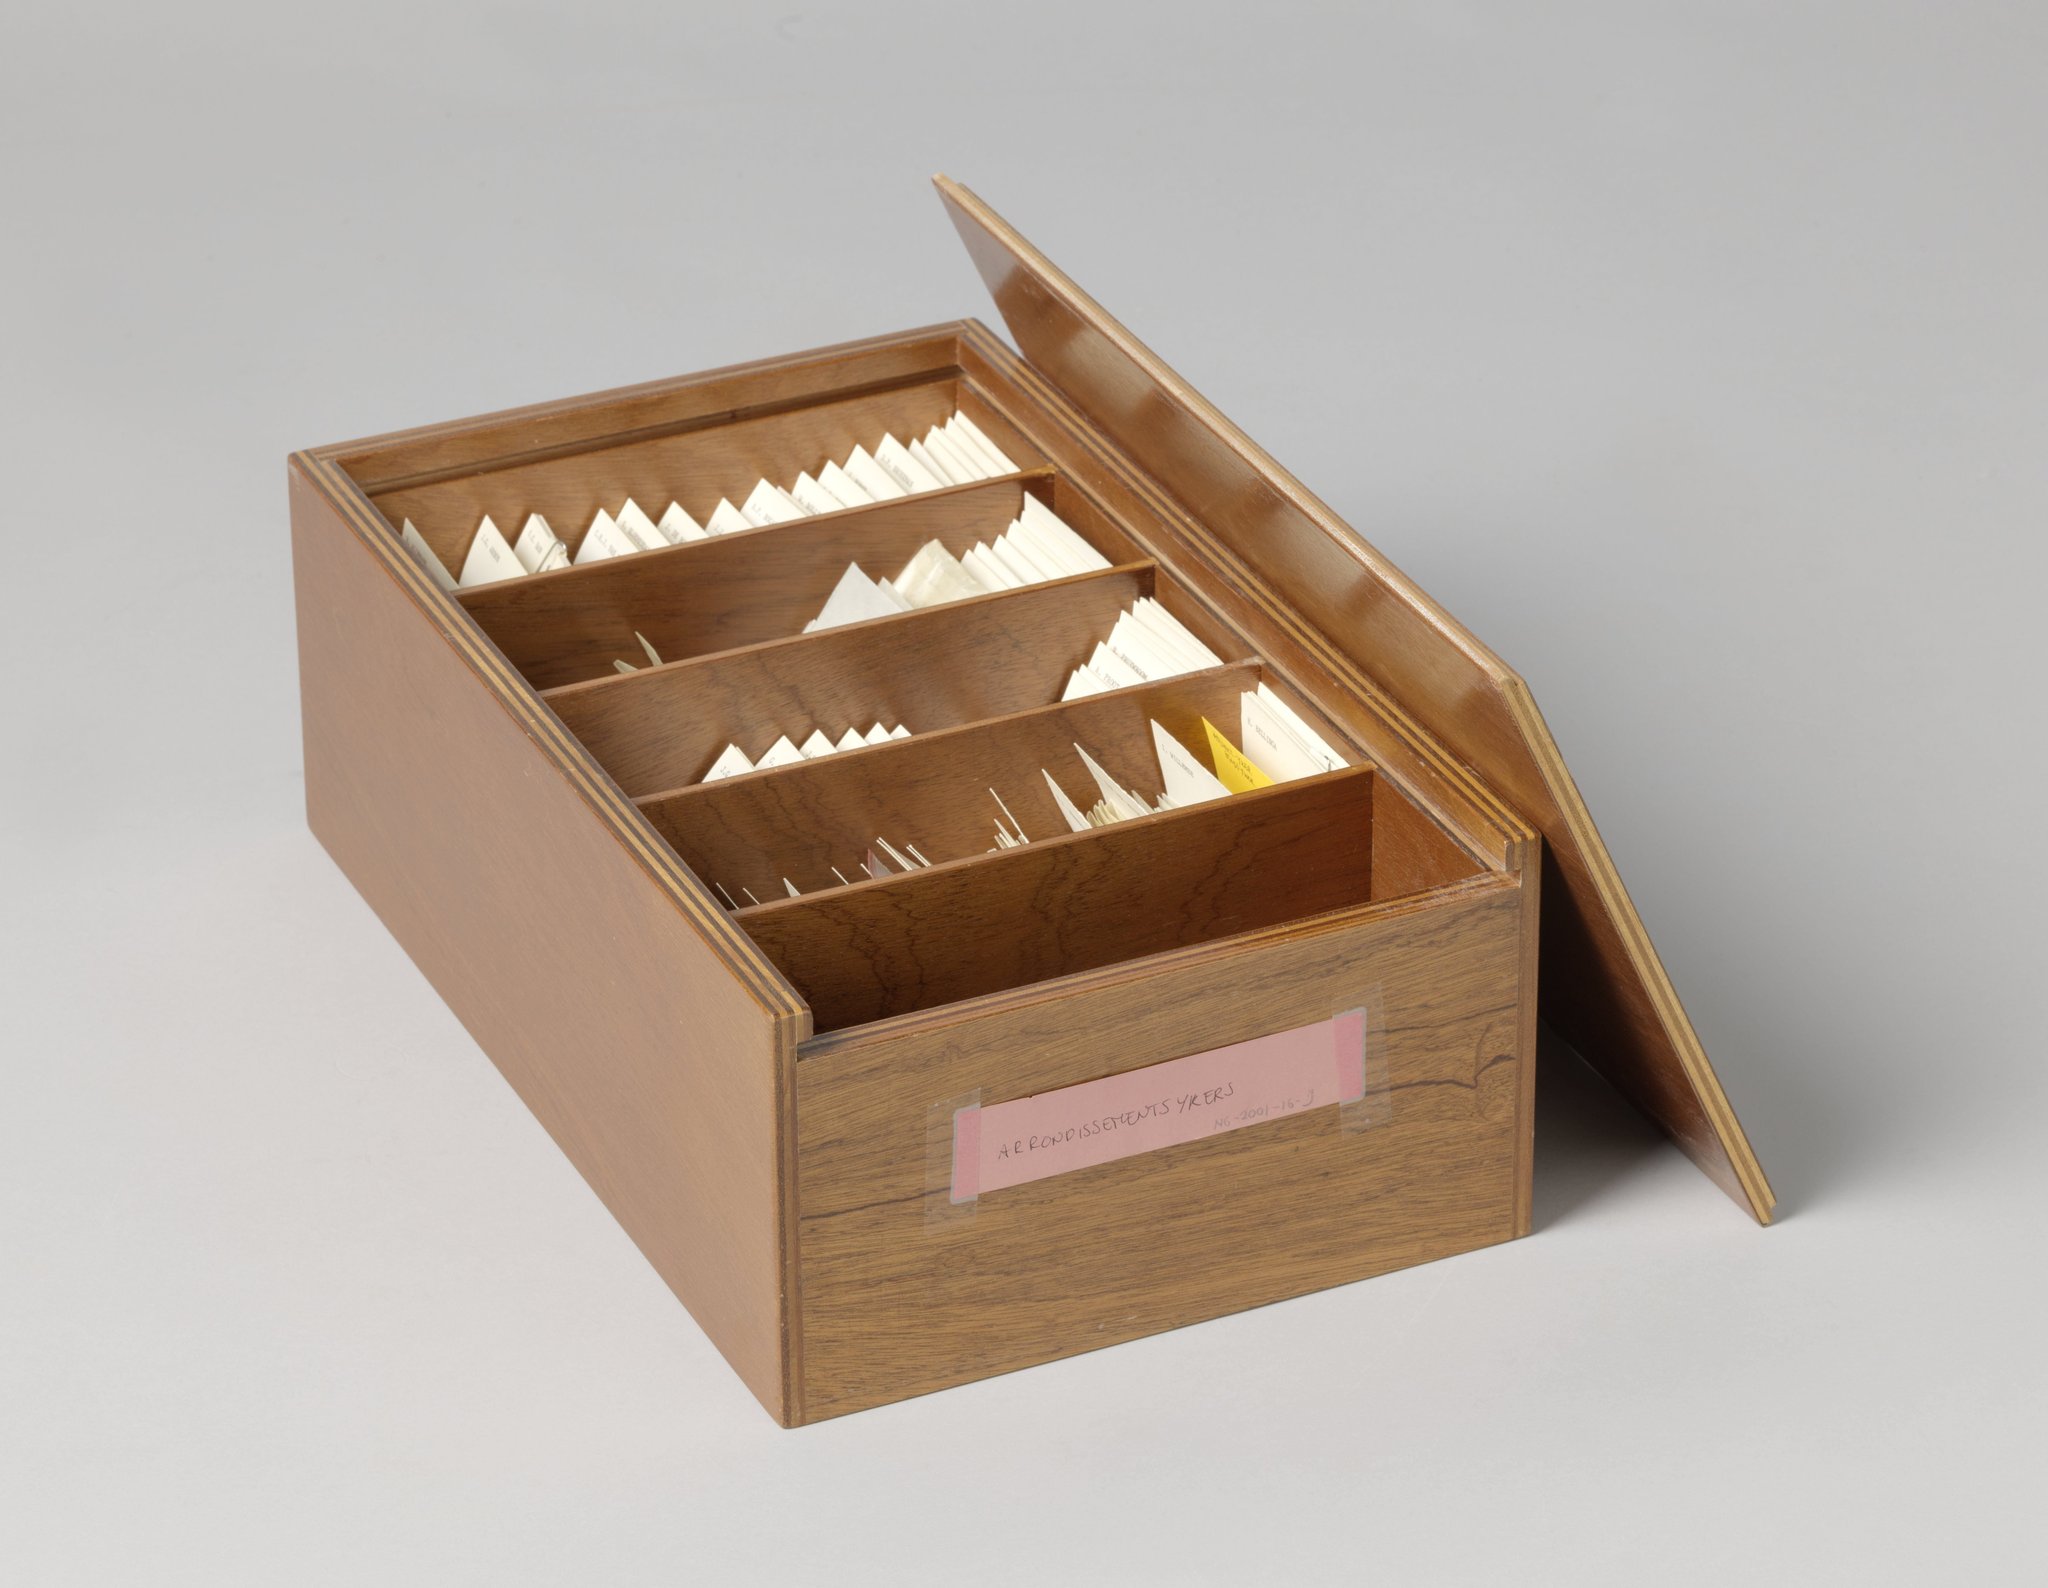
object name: chest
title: Goedkeuringsafslagen van arrondisementsijkers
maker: Anonymous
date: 1875-1997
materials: wood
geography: netherlands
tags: netherlands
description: Houten kist met schuifdeksel waarin goedkeuringsafslagen van arrondisementsijkers.